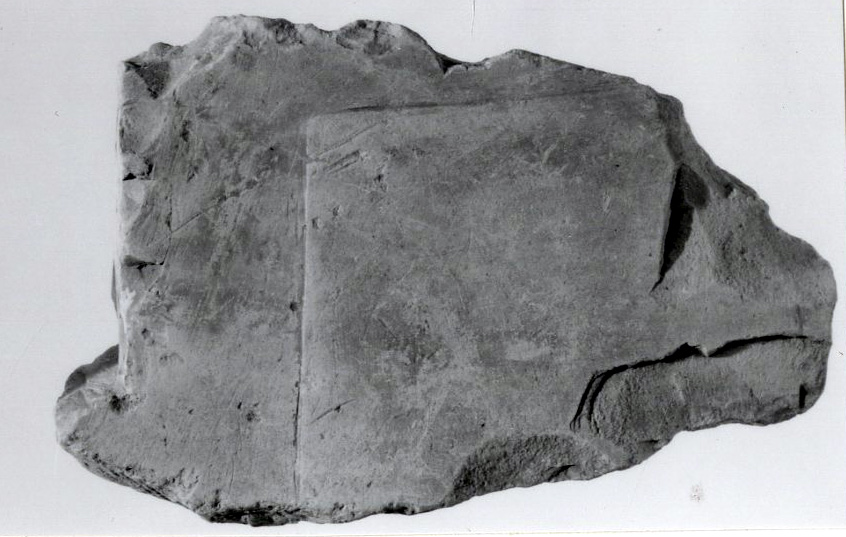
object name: relief fragment, tomb of meketre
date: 1981-1975 BCE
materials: limestone, paint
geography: egypt